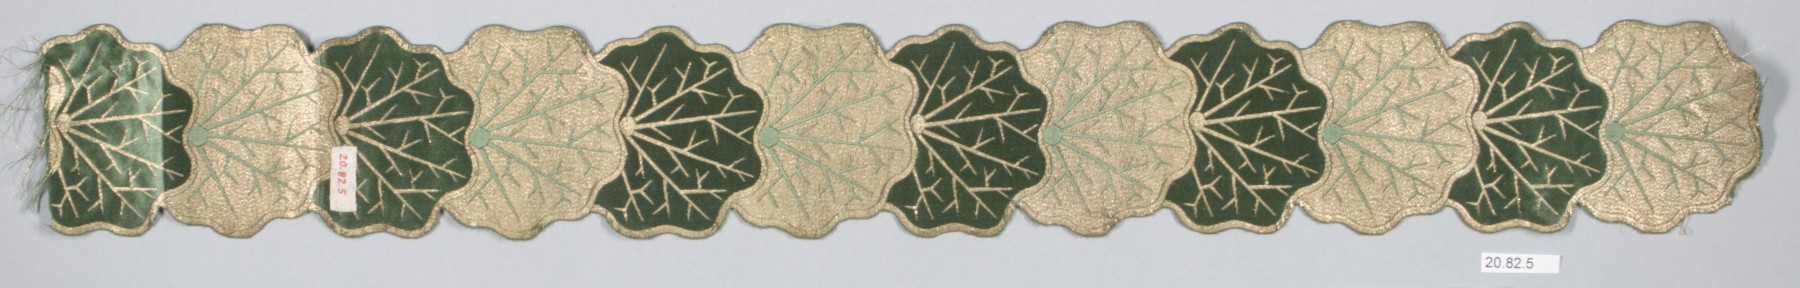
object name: ribbon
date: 1801-1833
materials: metal thread, silk